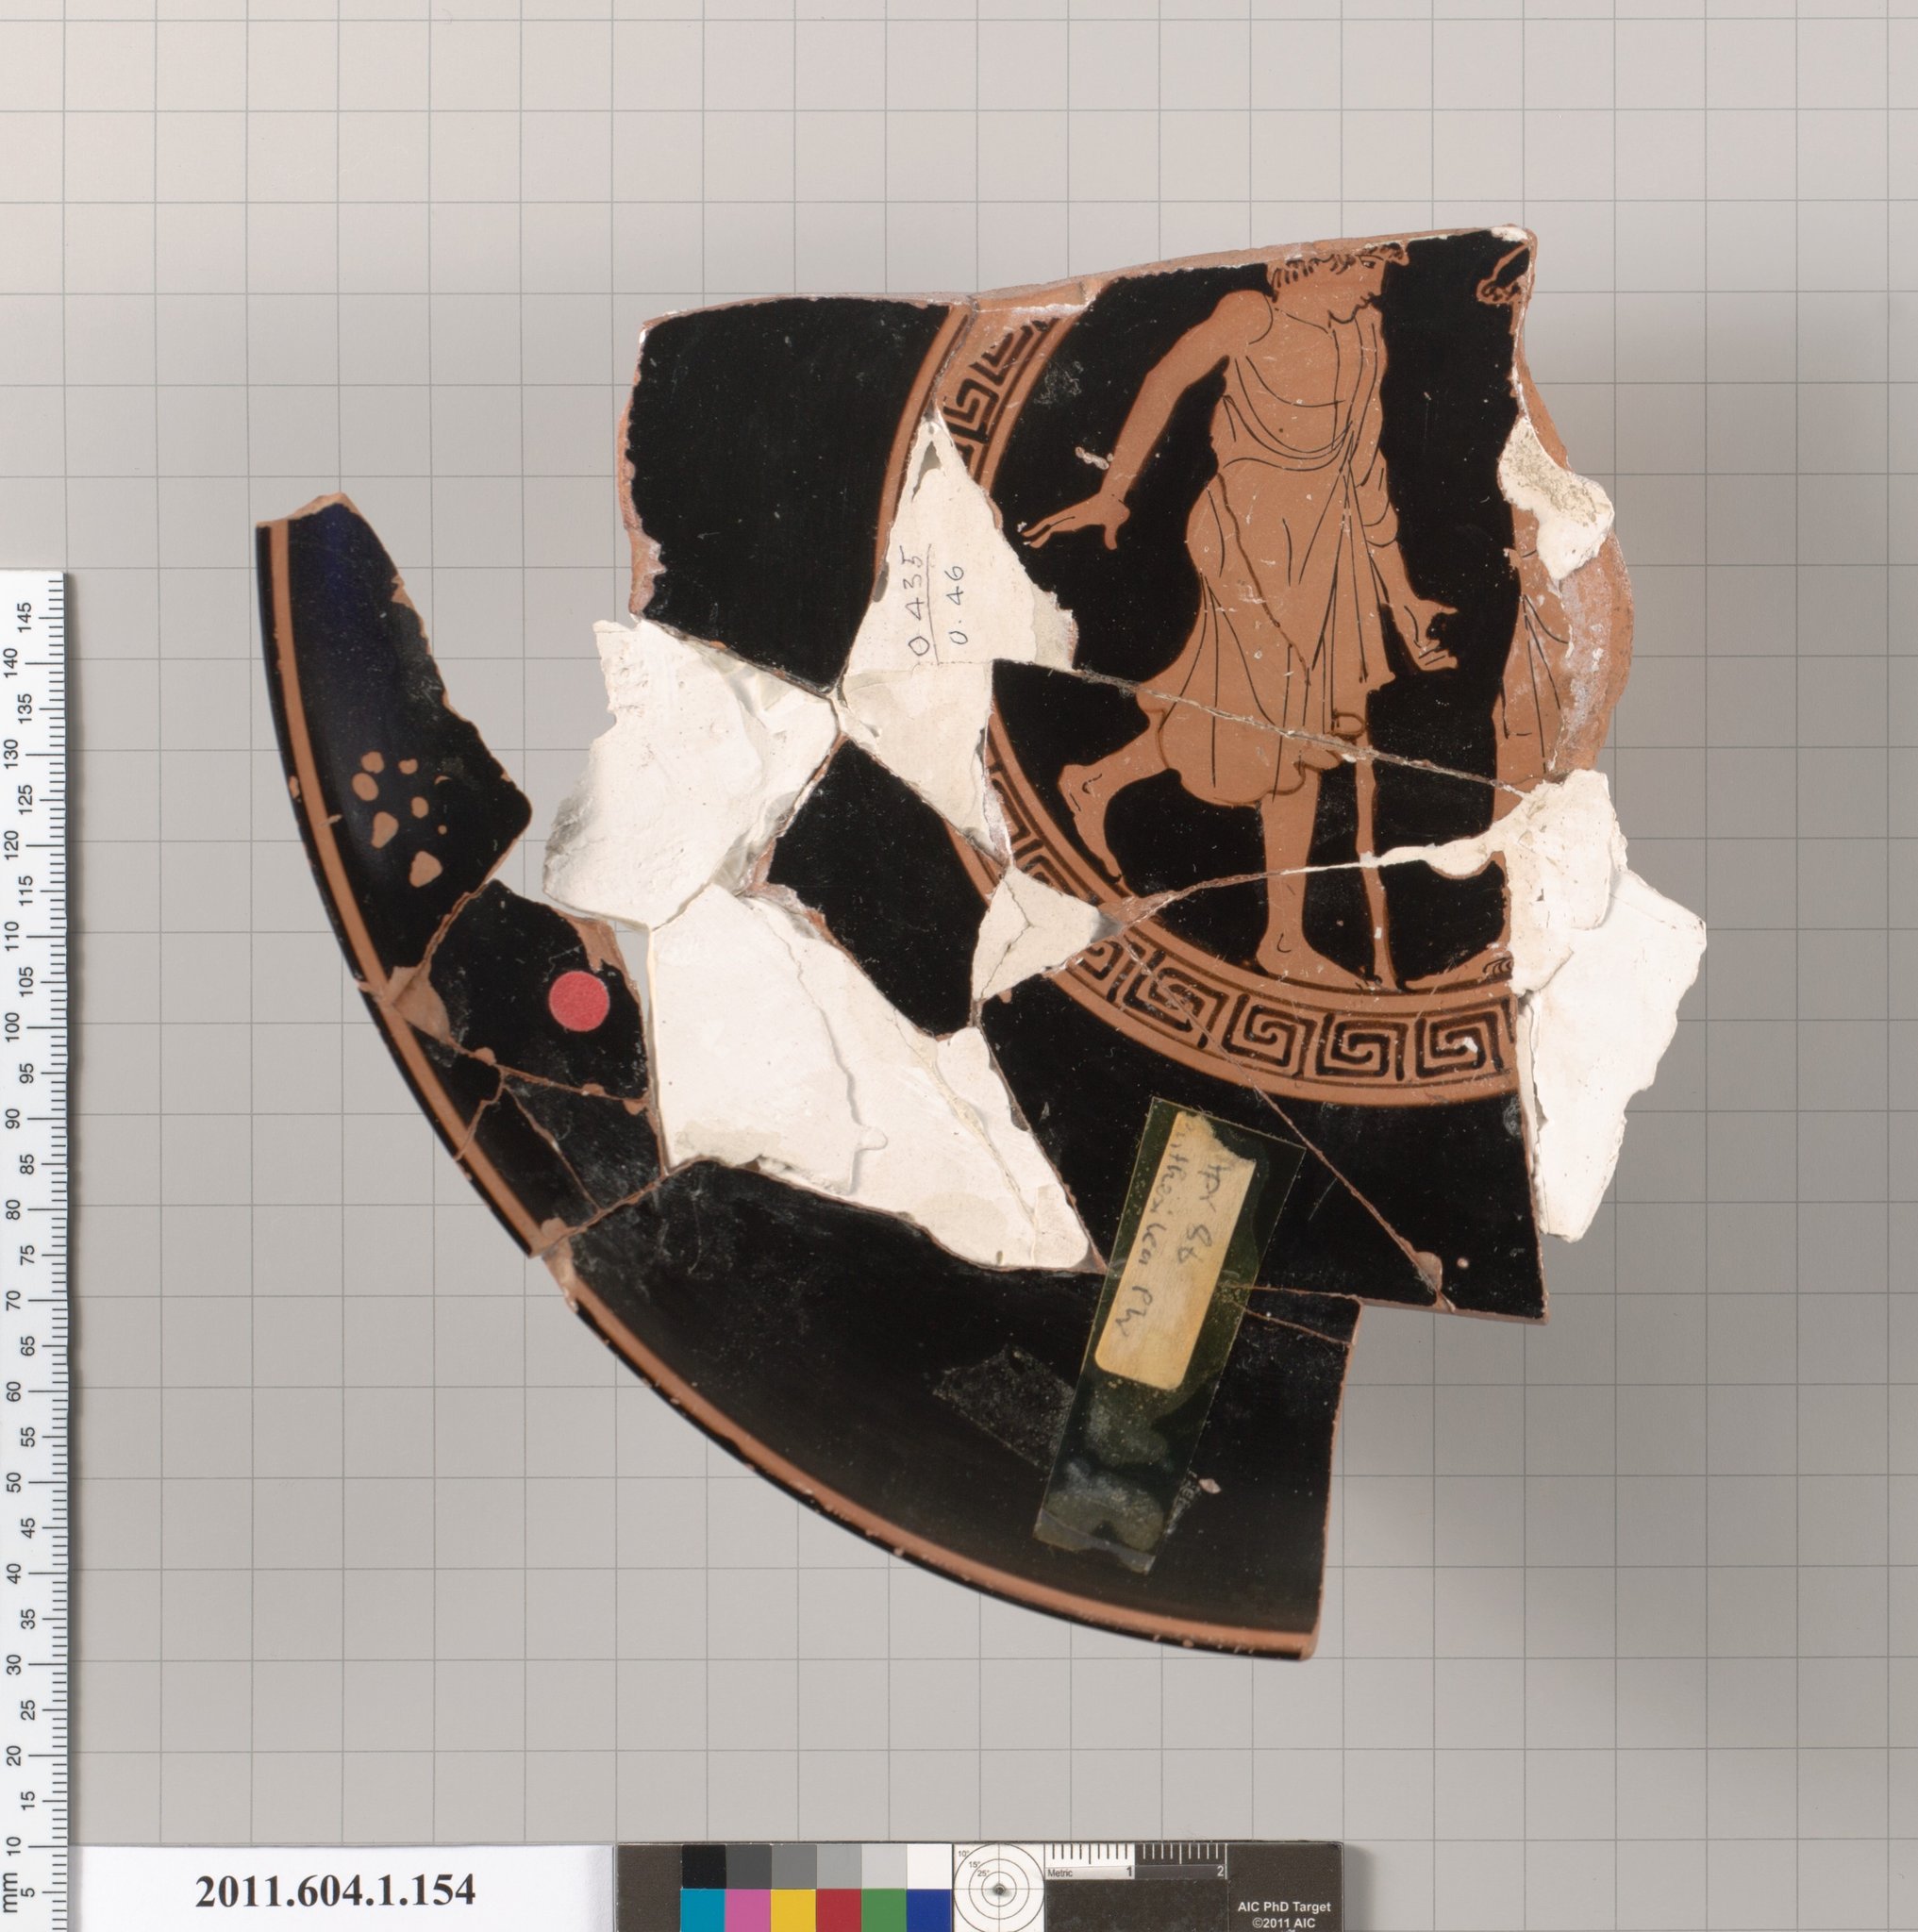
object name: kylix fragment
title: Terracotta fragment of a kylix (drinking cup)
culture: greek, attic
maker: penthesilea painter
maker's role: artist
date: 475-451 BCE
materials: terracotta